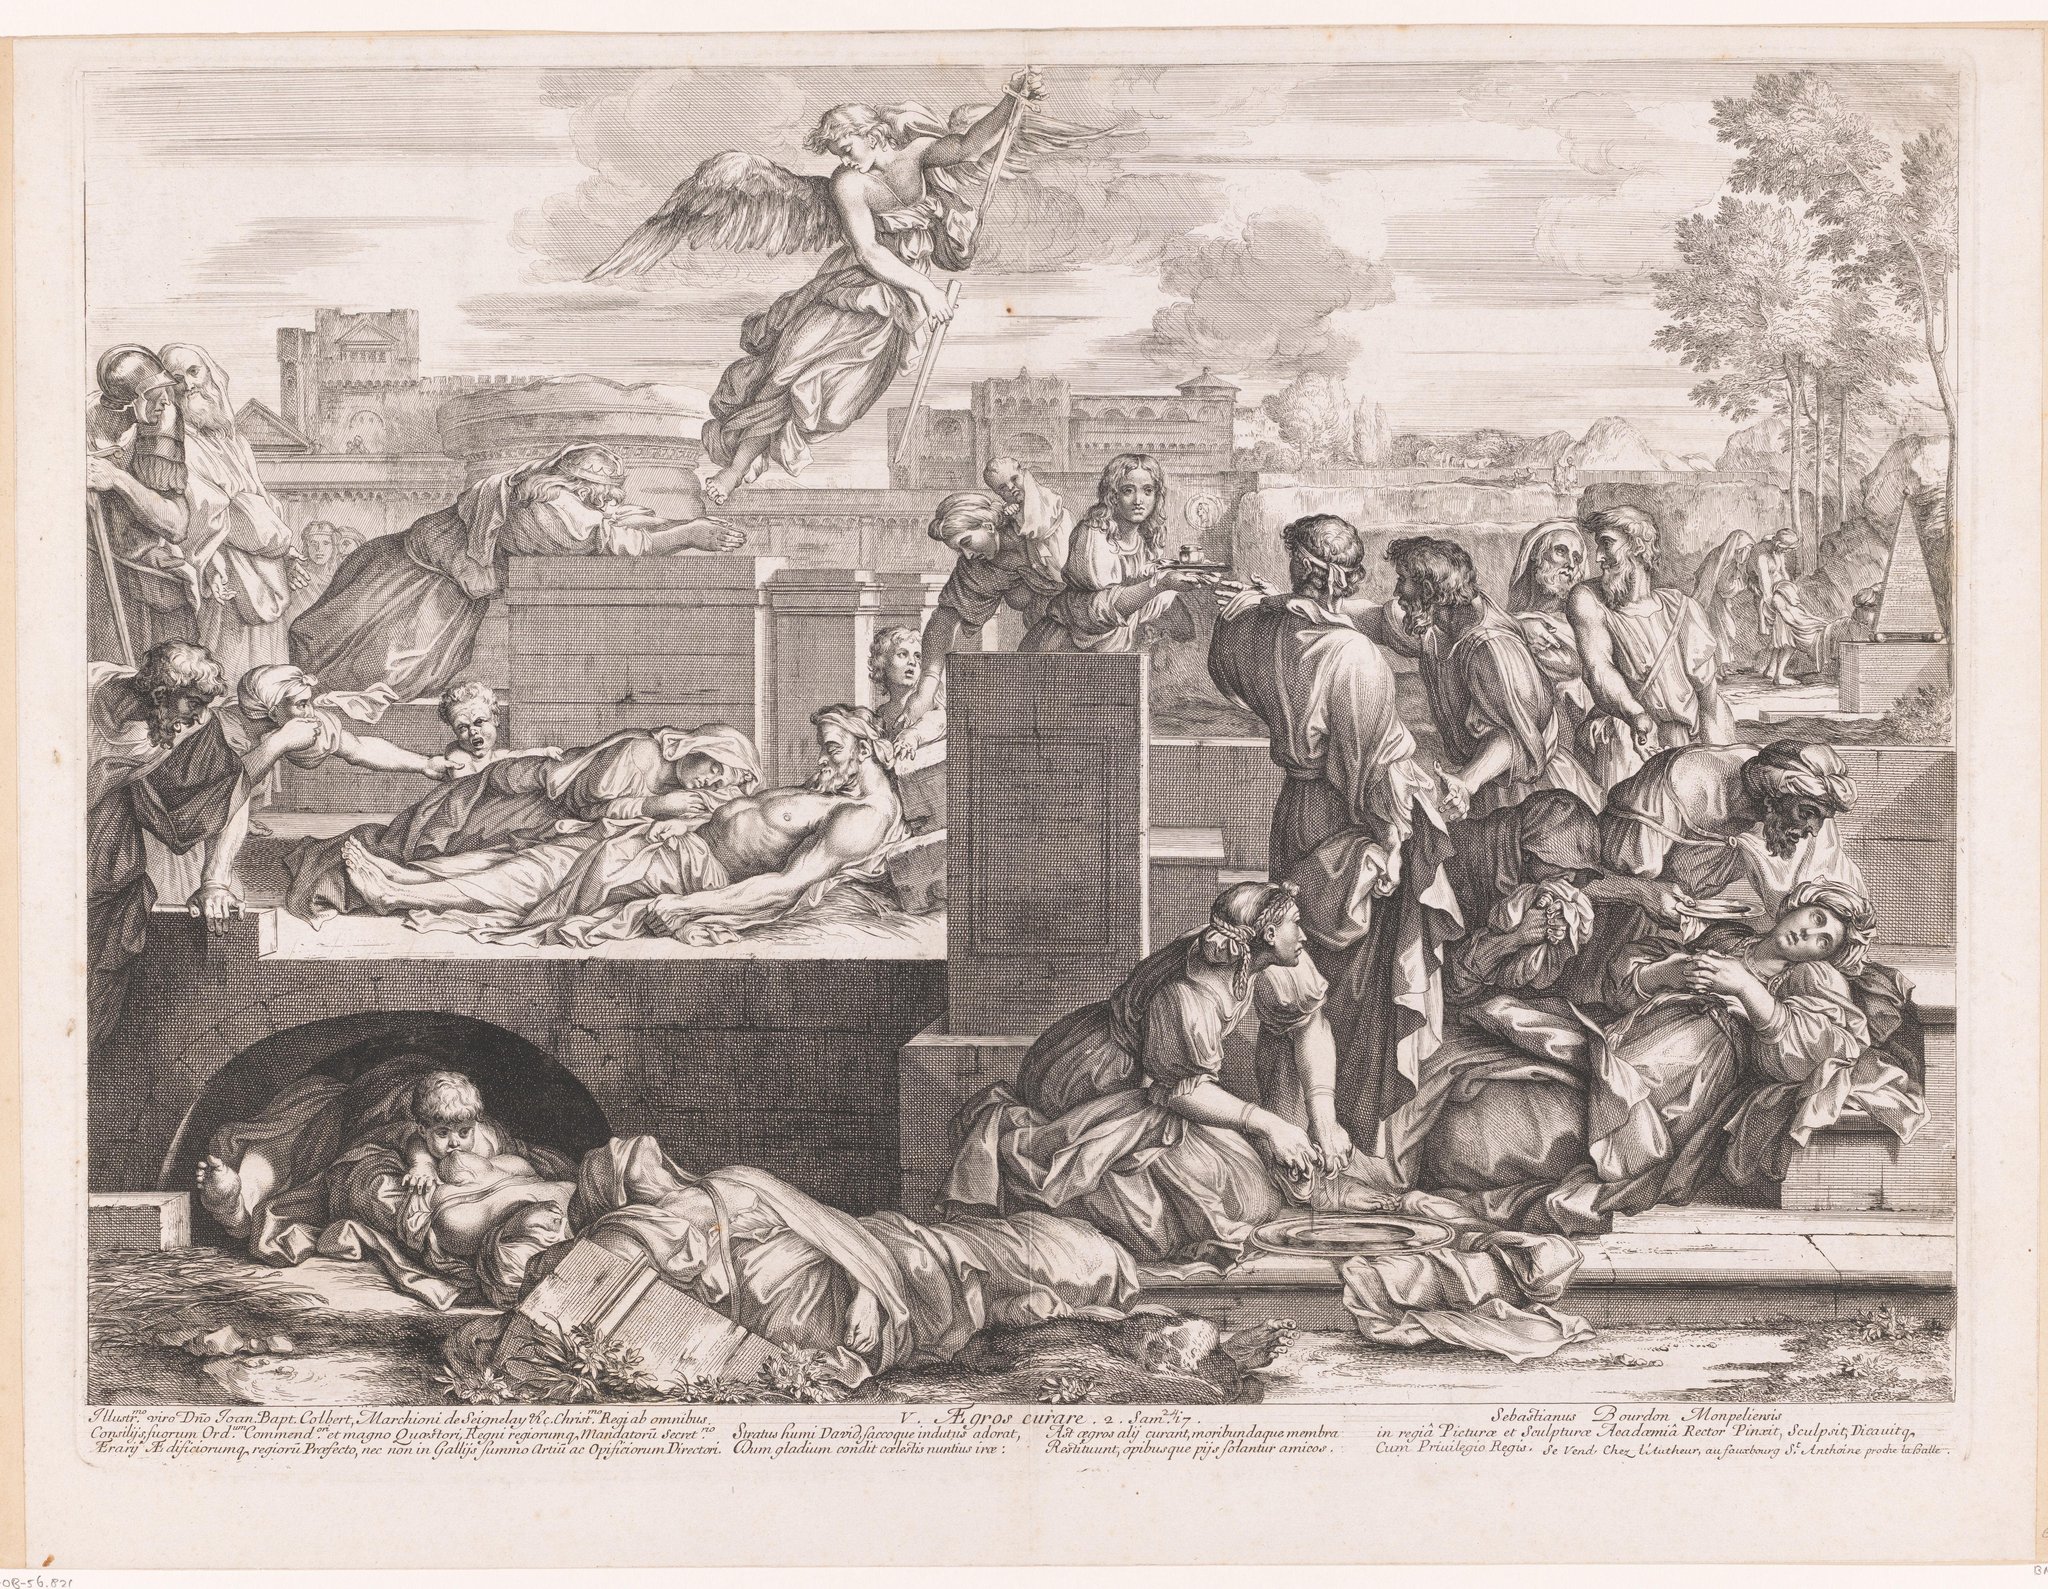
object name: print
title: Bezoeken van de zieken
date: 1626-1671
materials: paper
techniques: engraving, etching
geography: france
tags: david repentant; he lies on the ground praying and fasting for his child to recover, visiting the sick, 'aeger curatur' ~ one of the (seven) acts of mercy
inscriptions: collector's mark: Lugt 240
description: Maakt deel uit van een zevendelige serie met de zeven werken van barmhartigheid. De hele serie is opgedragen aan Colbert.